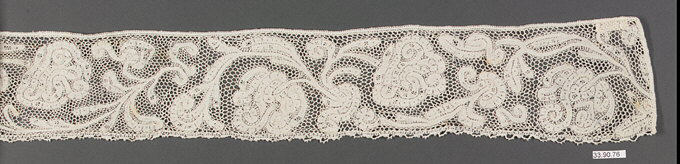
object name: edging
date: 1701-1733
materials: lace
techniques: lace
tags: flowers